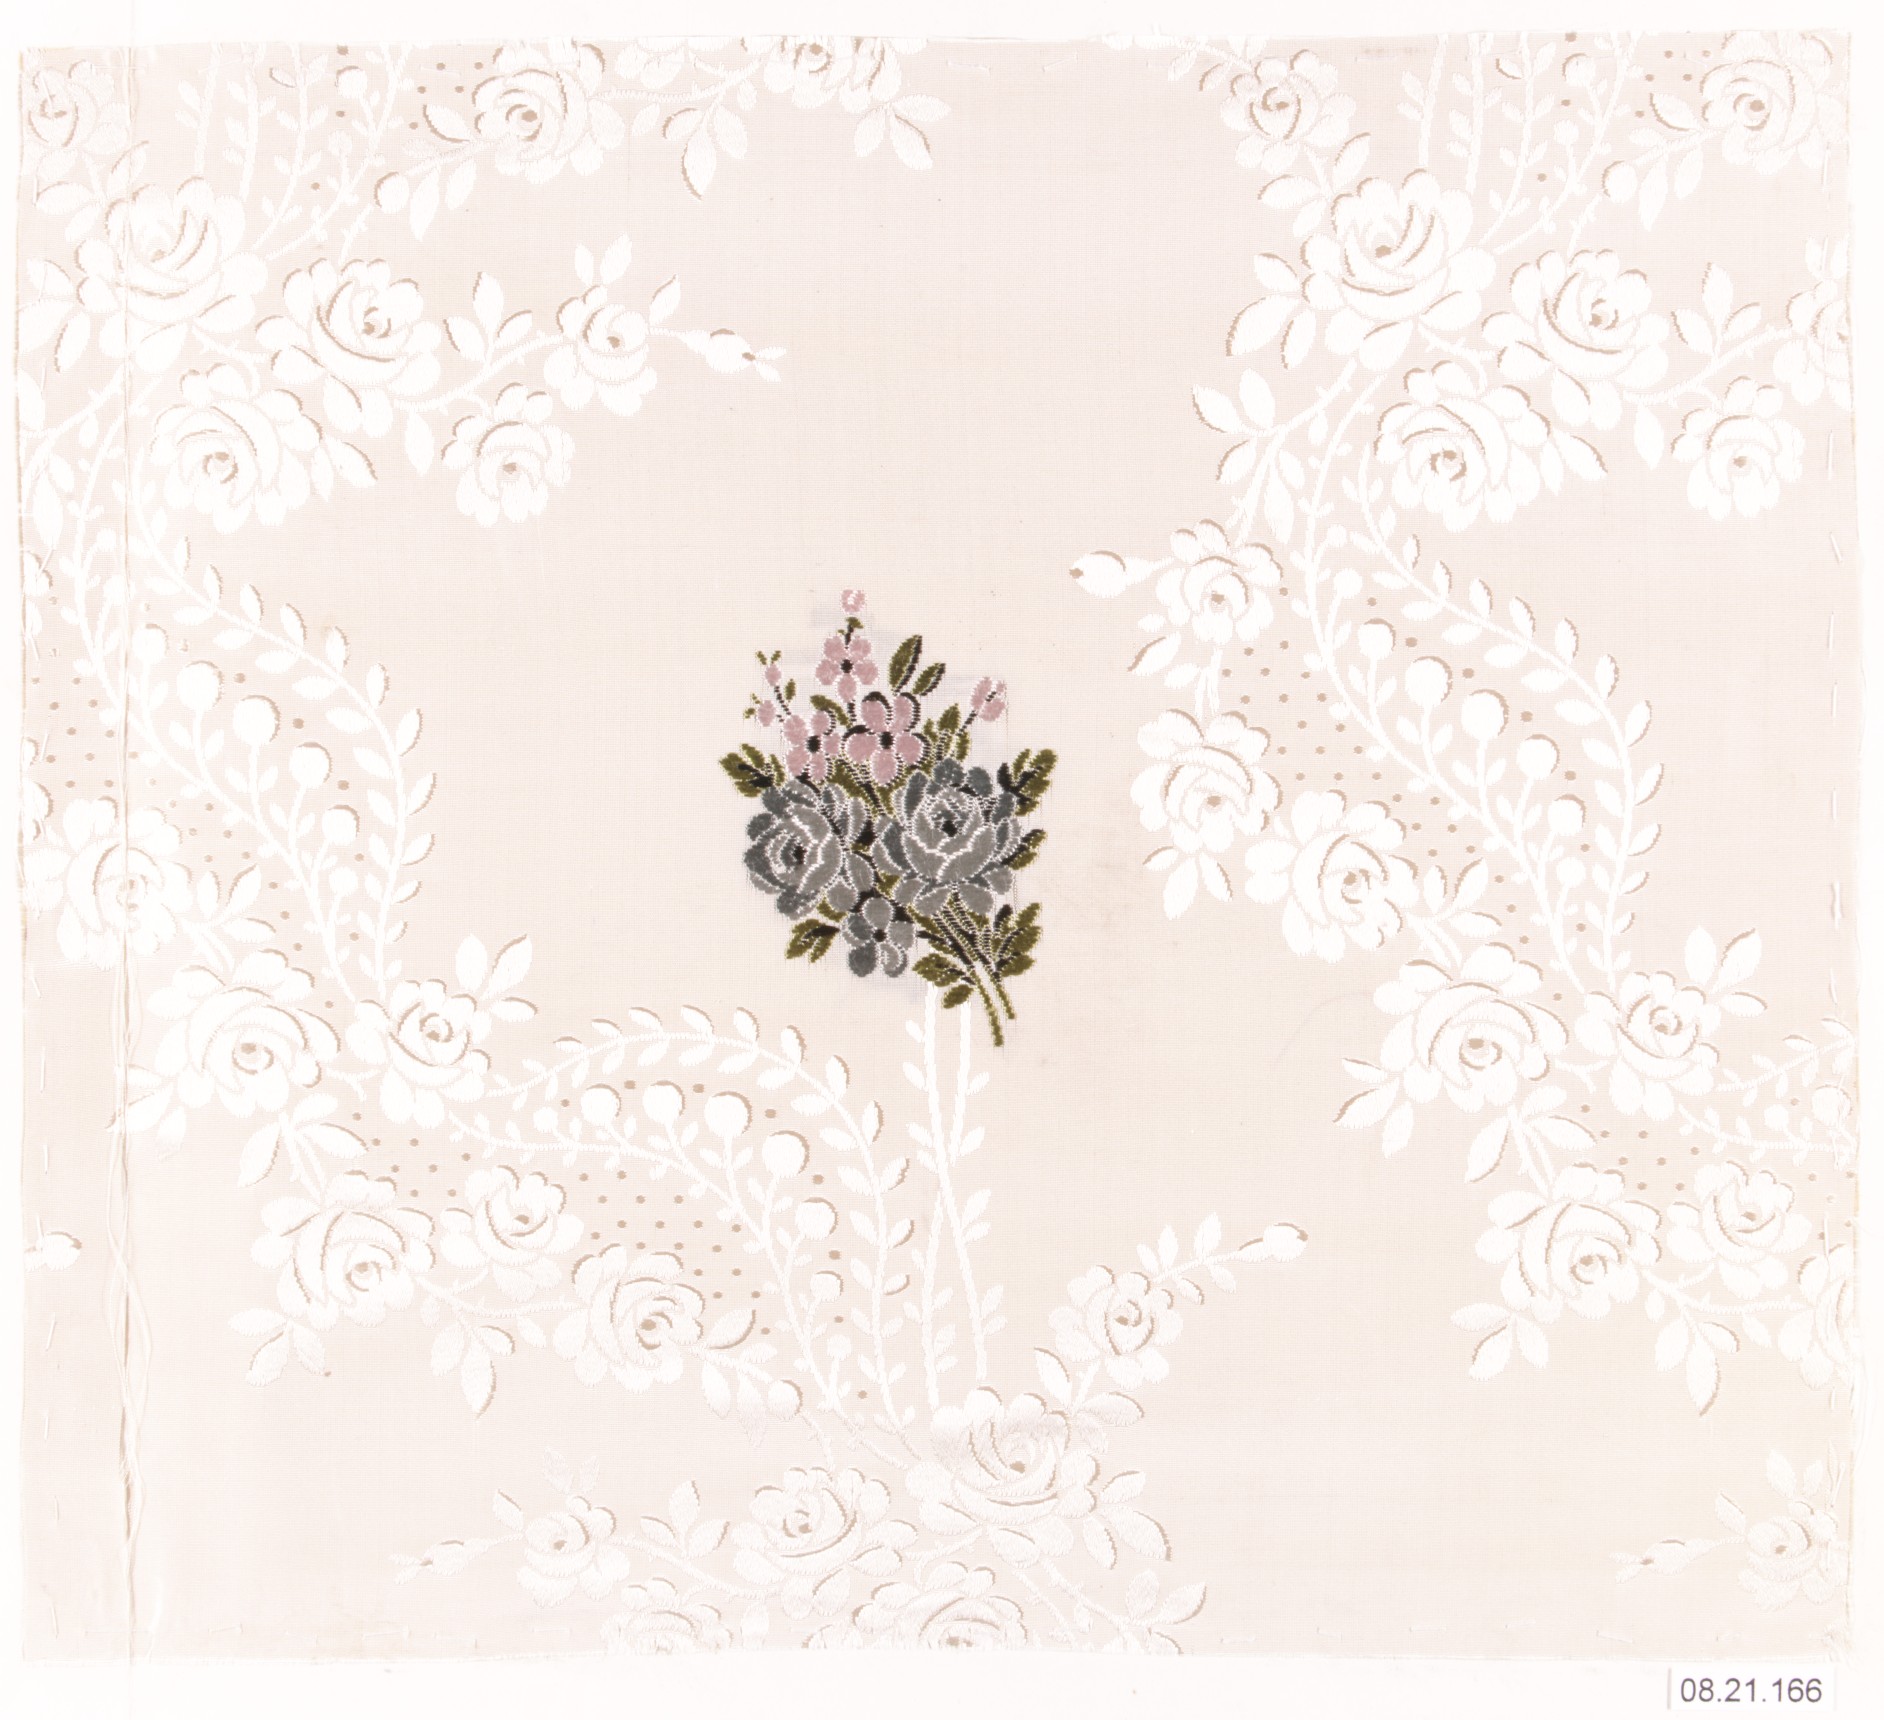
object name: textile sample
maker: Anonymous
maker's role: designer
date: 1900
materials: silk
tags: flowers